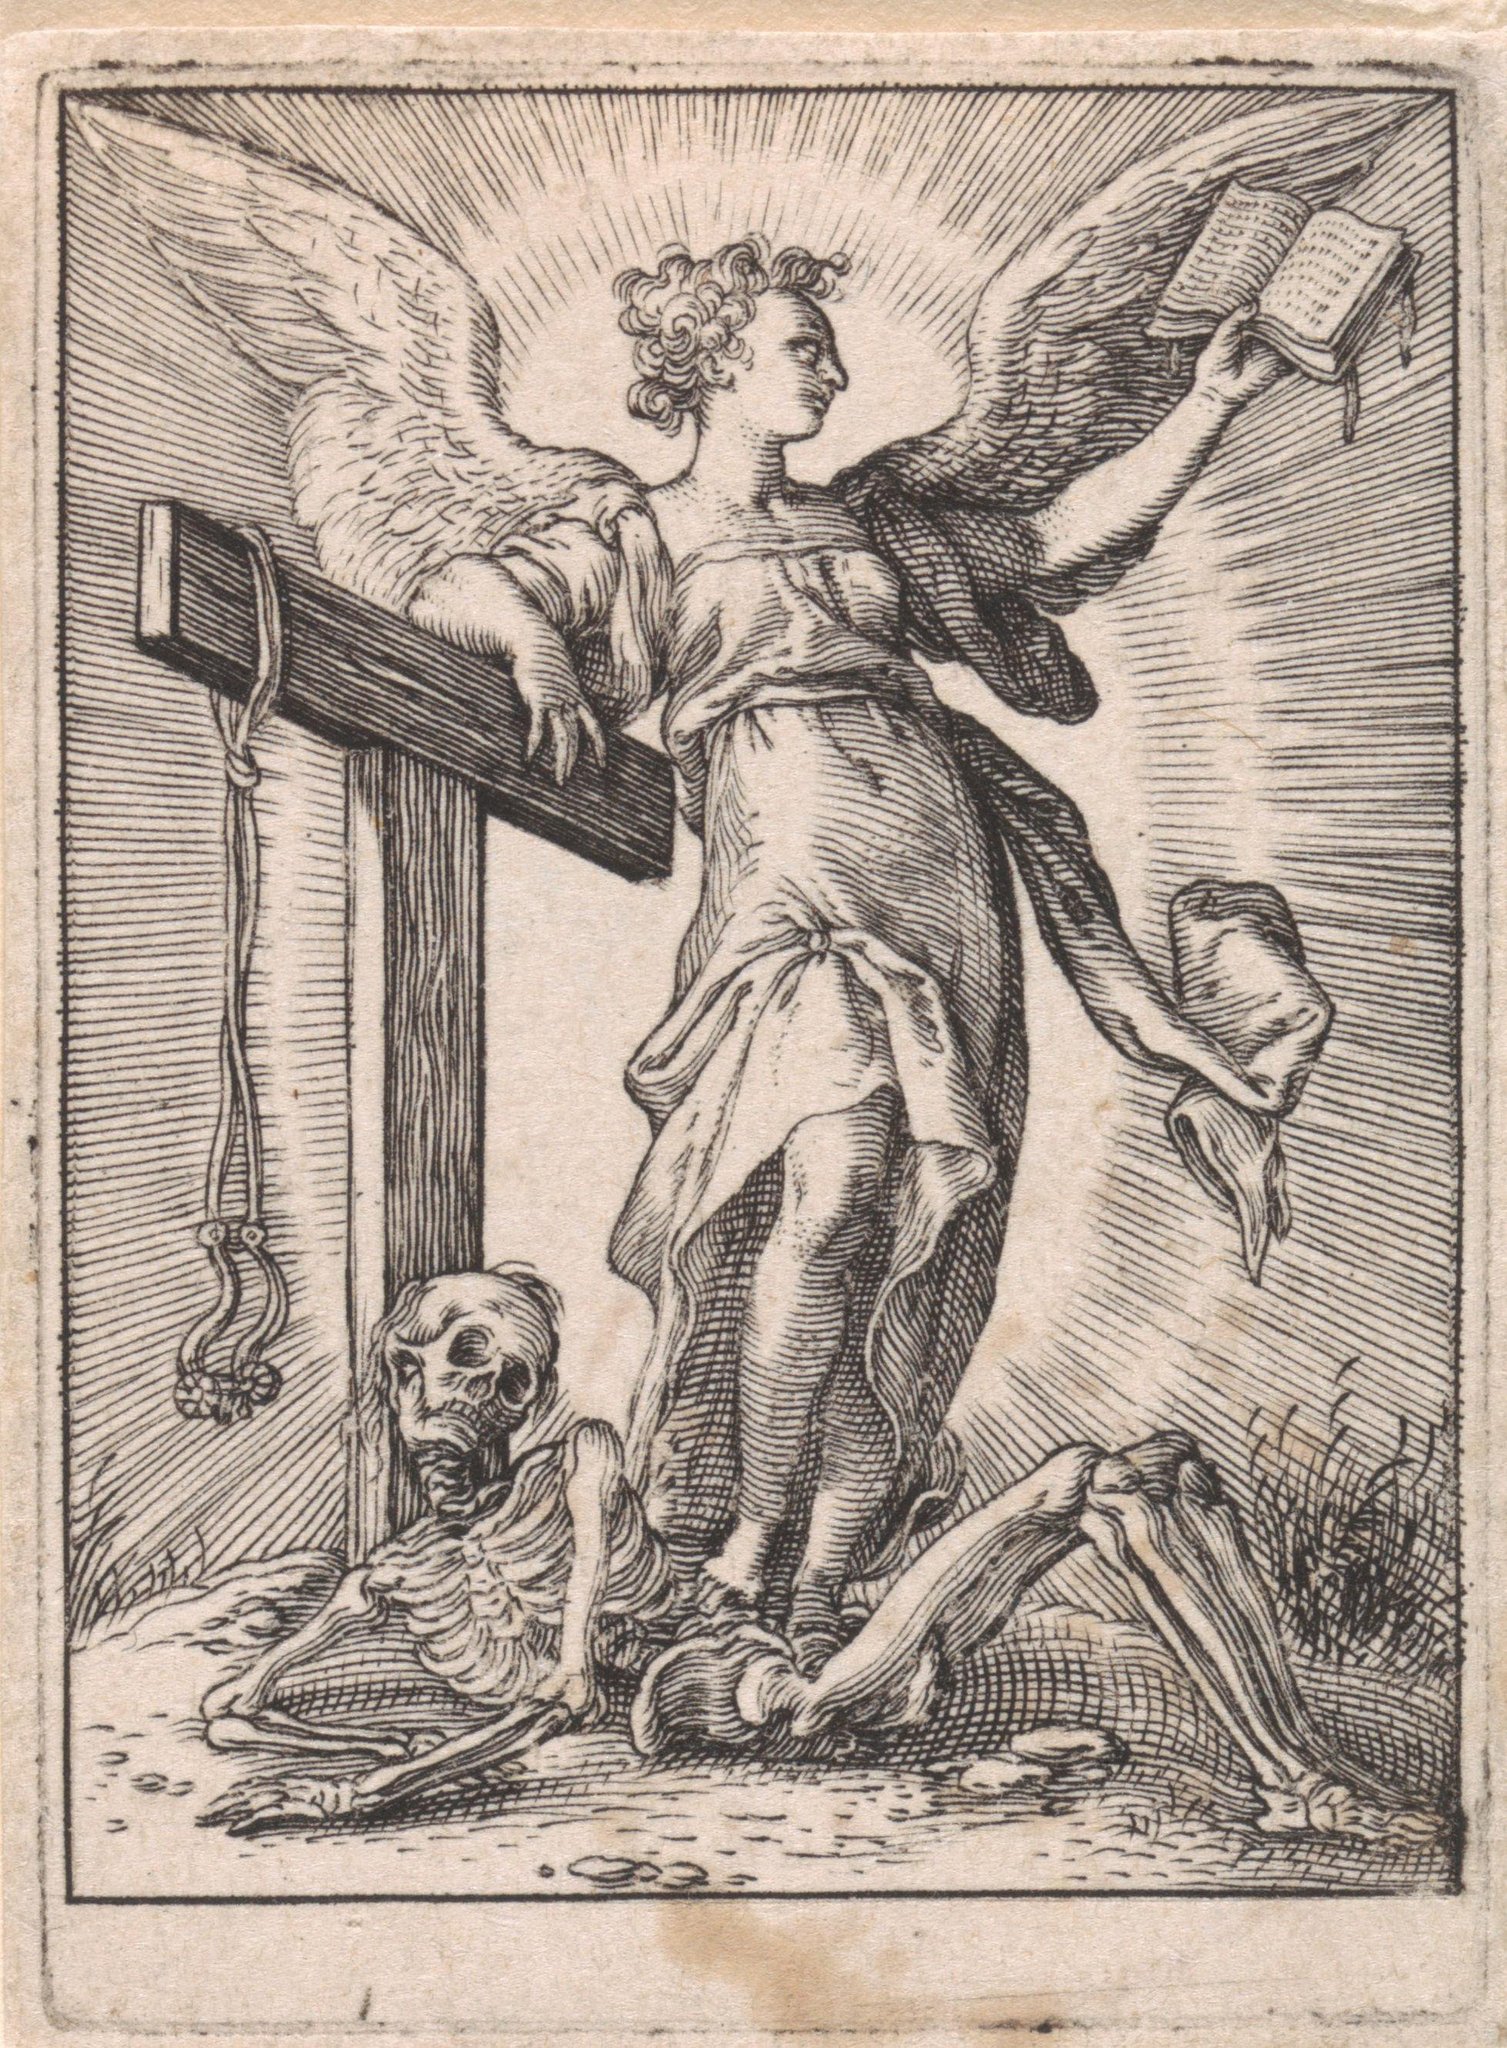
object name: print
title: Overwinning op de Dood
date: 1601-1667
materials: paper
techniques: engraving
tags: death as skeleton, victoria as roman personification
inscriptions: collector's mark: Lugt 240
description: Overwinning van het Geloof, in de gedaante van een engel met een Bijbel in de hand, staat met haar voet op het skelet van de dood. Ze leunt op een kruis waaraan een paardentoom hangt.